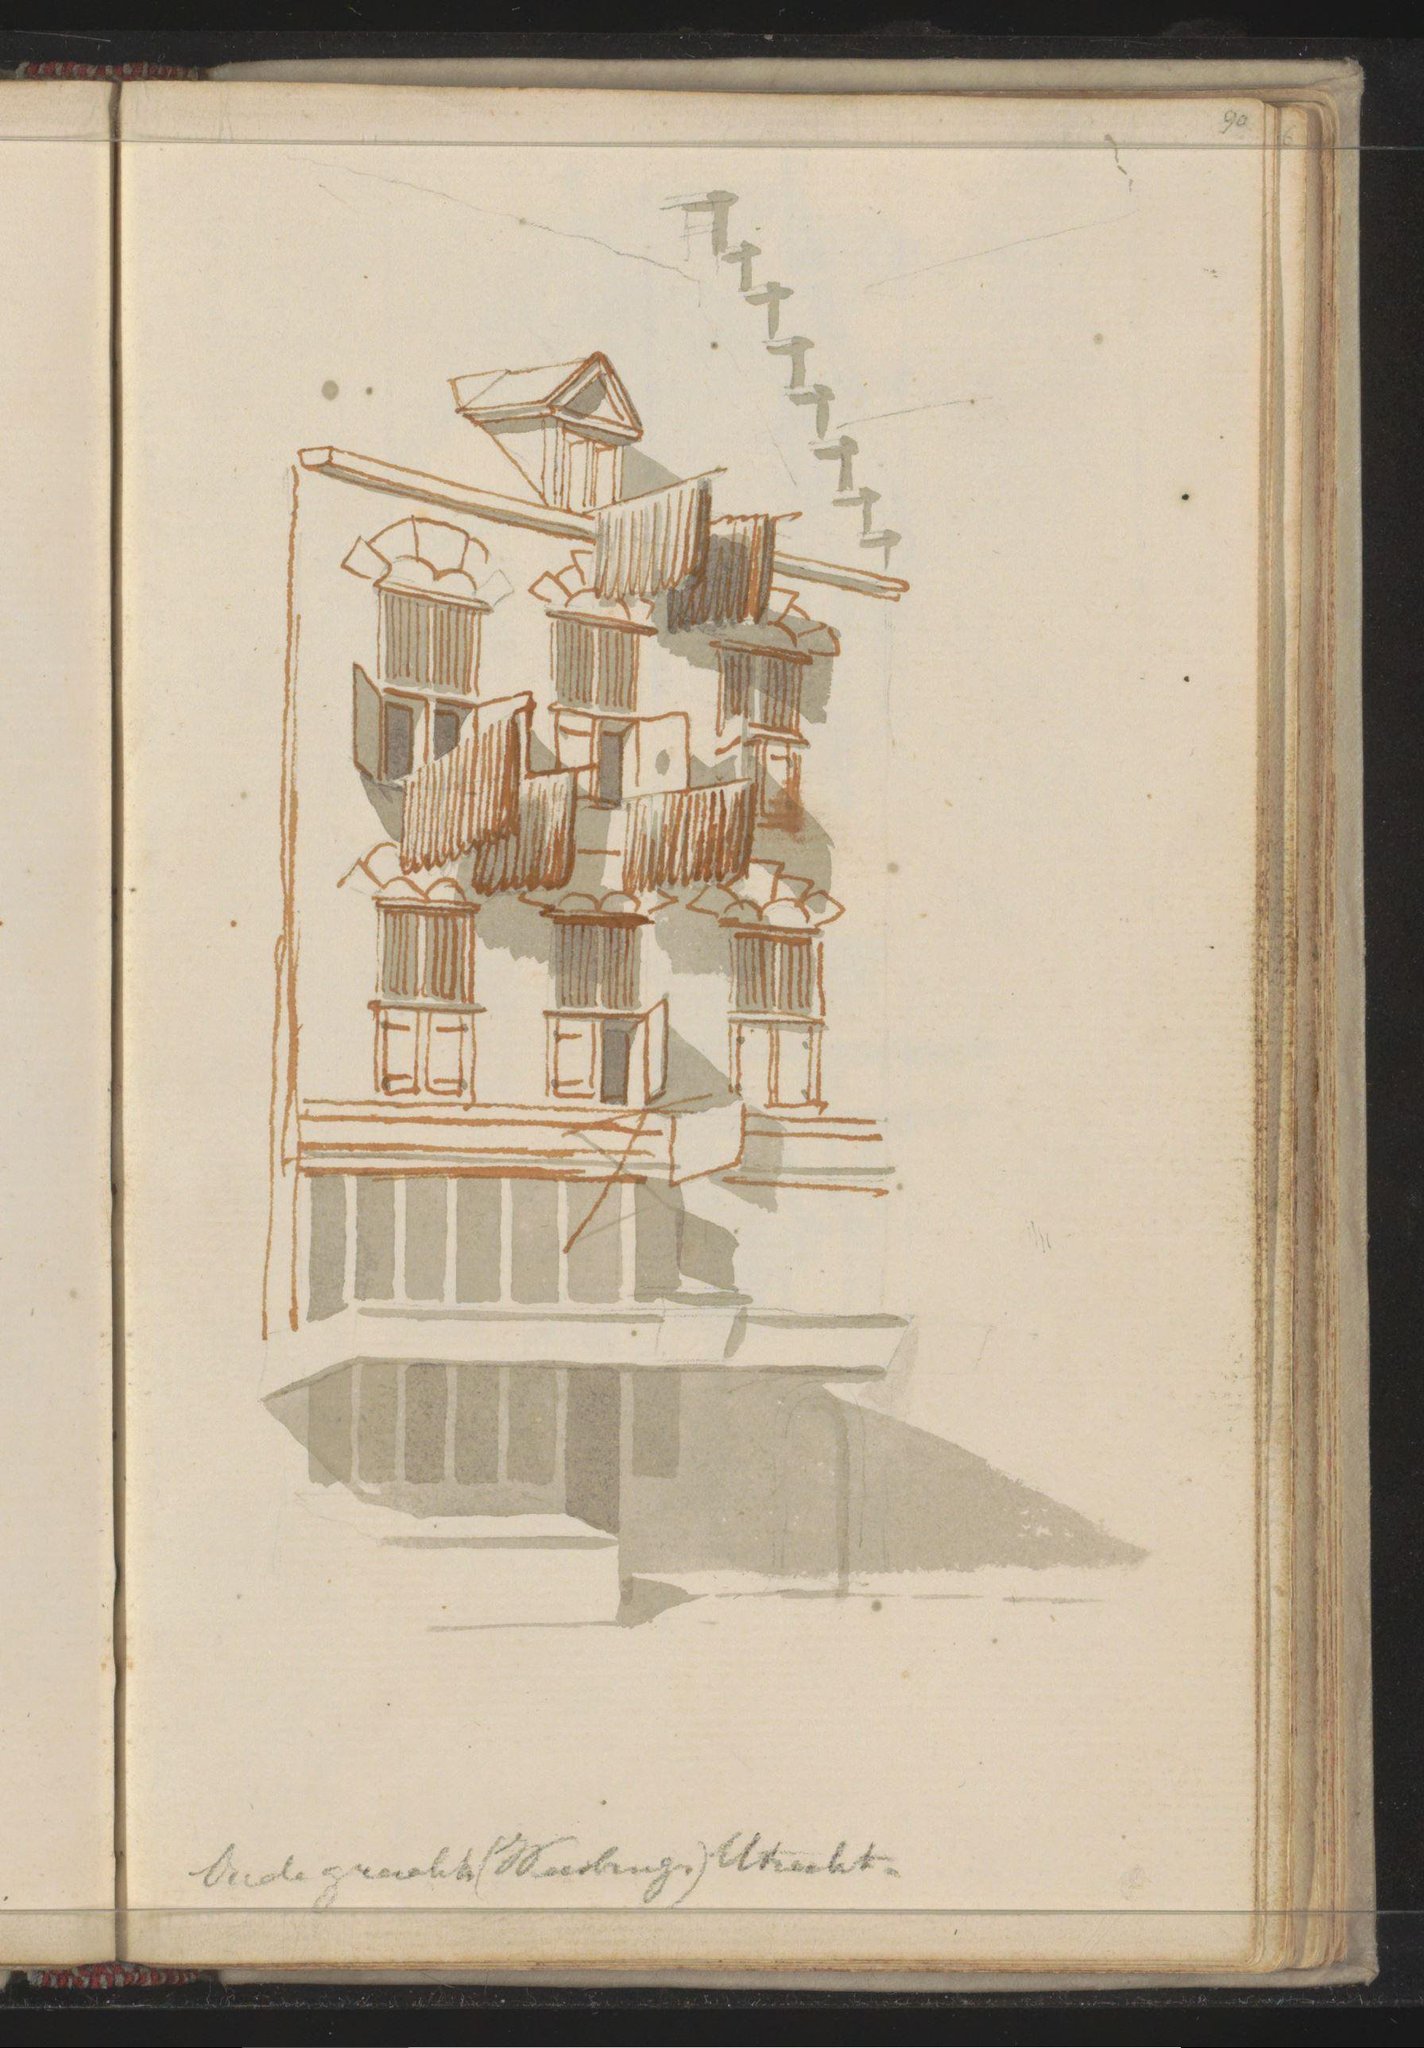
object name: sketchbook leaf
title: Gevel van een pand aan de Oudegracht te Utrecht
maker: johannes huibert prins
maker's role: draughtsman, painter, print maker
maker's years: 1757-1806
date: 1783-1797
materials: ink, paper, pencil, watercolor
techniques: brush, pen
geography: utrecht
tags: façade (of house or building)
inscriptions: annotation: ‘Oude gracht (Weesbrug) Utrecht’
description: Pagina 90 uit een schetsboek met 175 pagina's.